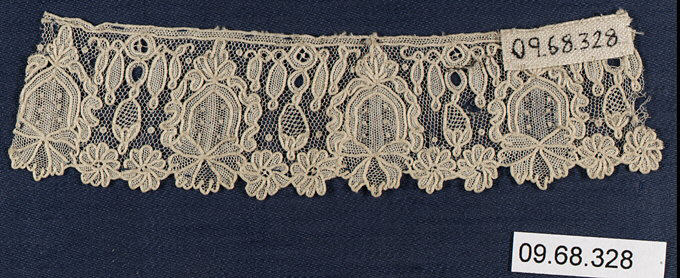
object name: fragment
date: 1801-1900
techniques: lace